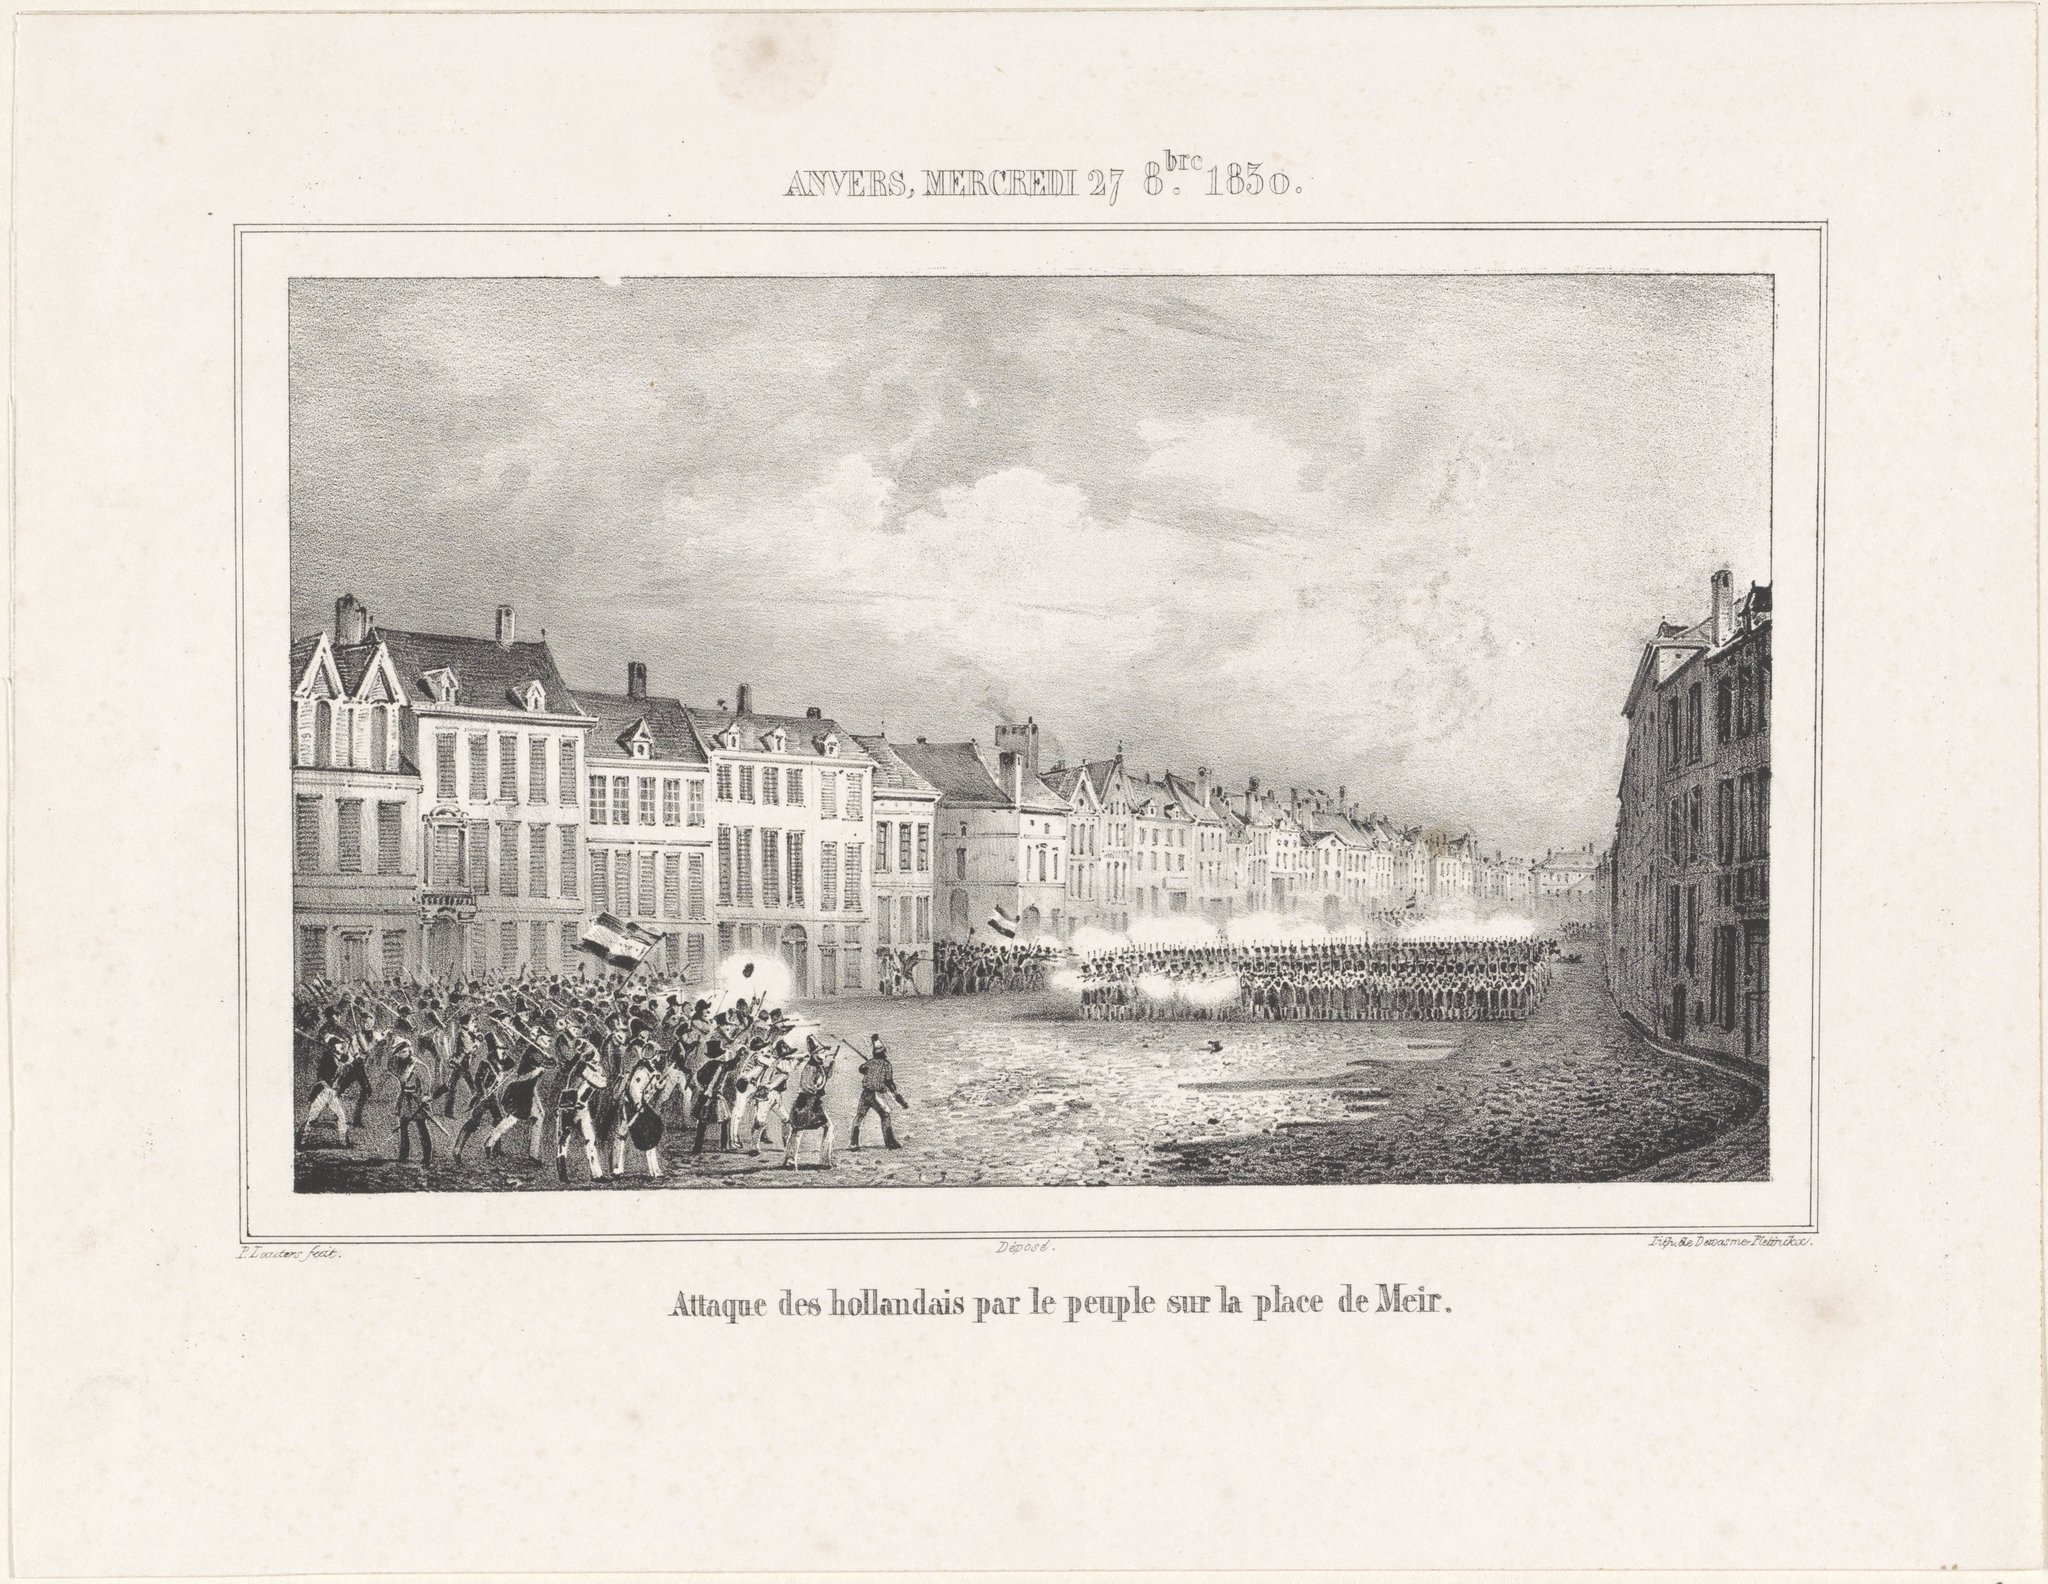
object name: print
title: Evénemens de Bruxelles, Anvers (...) (1831)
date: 1830-1831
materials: paper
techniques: lithograph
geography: brussels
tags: street-fights, riots, antwerp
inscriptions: collector's mark: Lugt 2228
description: Gevechten op de Meir te Antwerpen tussen Belgische opstandelingen en Nederlandse troepen, 27 oktober 1830. Onderdeel van een recueil met platen over de gebeurtenissen tijdens de Belgische Revolutie in Brussel, Antwerpen en andere steden in de periode 25 augustus 1830 tot 27 maart 1831.